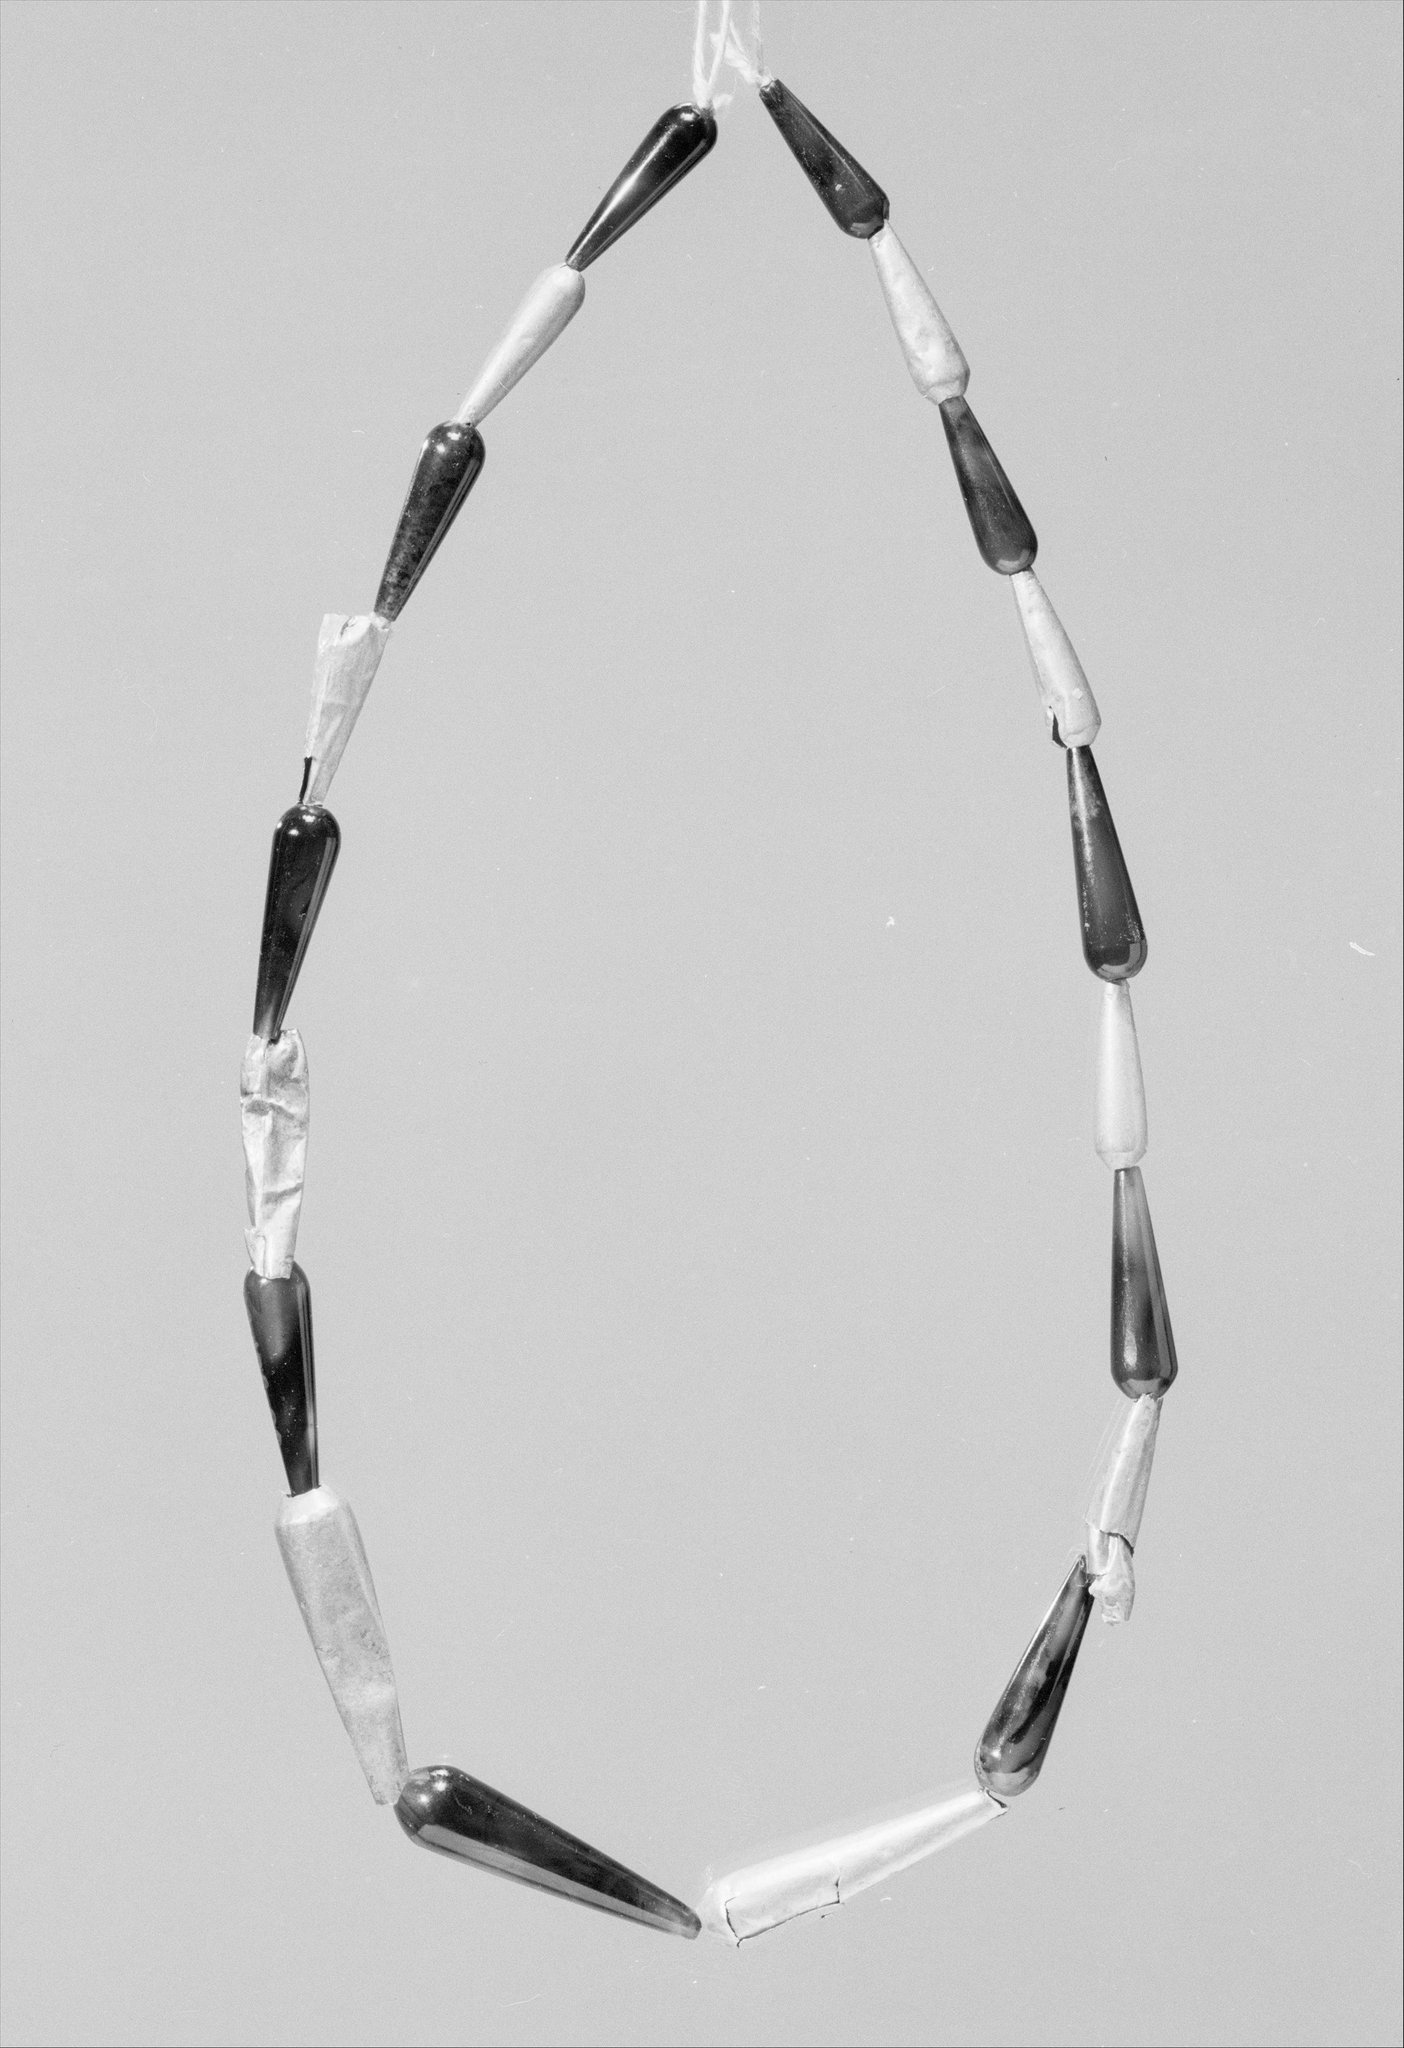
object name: necklace, bead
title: Nineteen Drop Beads here Strung as a Necklace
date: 1648-1540 BCE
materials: gold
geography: eastern delta